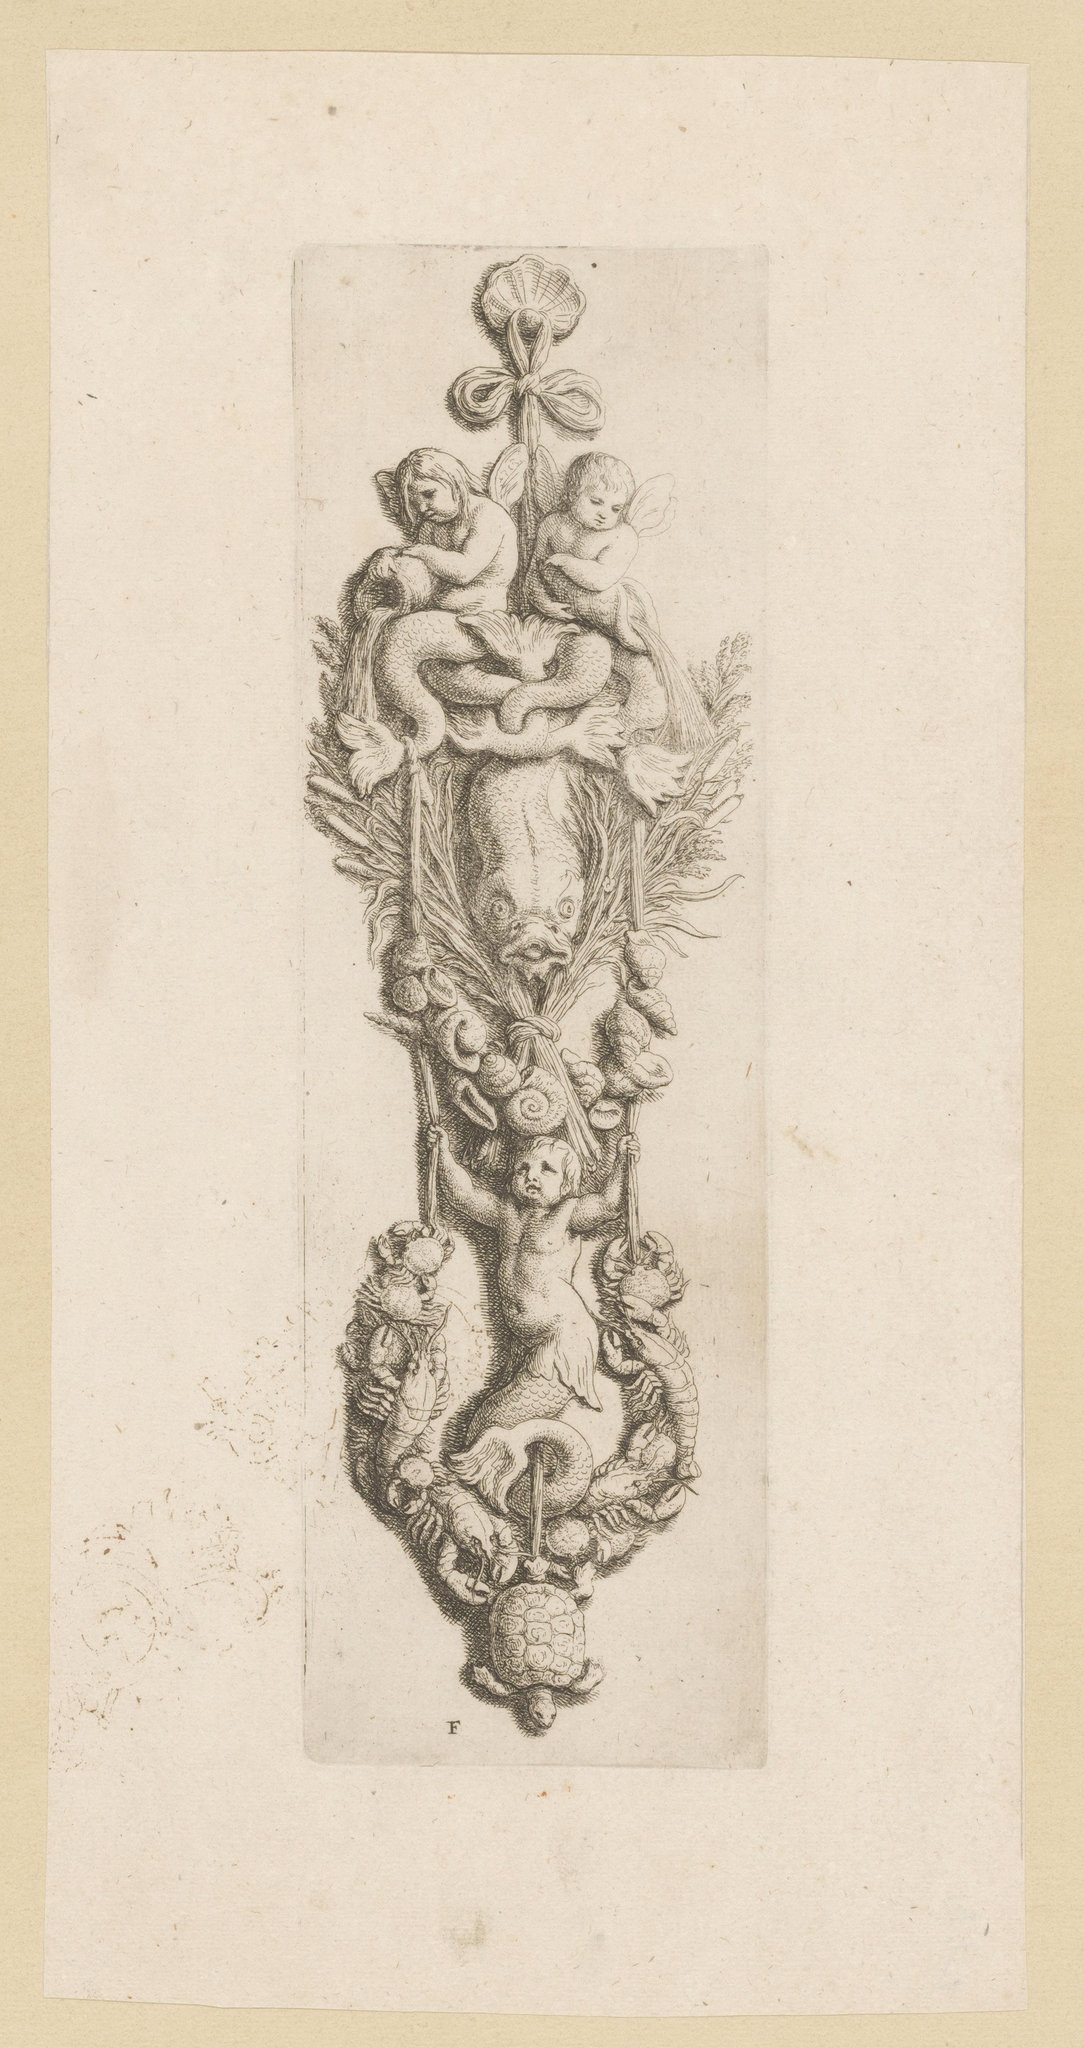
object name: print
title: Festoen met attributen van de personificatie van het element Water aan westzijde van de Burgerzaal in het Stadhuis op de Dam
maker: hubert quellinus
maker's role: print maker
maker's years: 1619-1687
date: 1663-1668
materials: paper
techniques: engraving, etching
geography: amsterdam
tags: water (one of the four elements), townhall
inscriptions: collector's mark: ‘16,75’ Lugt 1641b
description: Huidige staat van prent ook gebruikt in: Secunca pars Praecipuarum effigierum ac ornamentorum amplissime Curiae Amstelrodamensis maiori ex parte in cadido marmore effectorum per Artum Quellinium eiusdem Civitatis Statuarium / Het tweede deel Van de voornaemste Statuen ende Cieraten van 't konst-rijcke Stadt-huys van Amstelredam 'tmeeste in Marmer gemaeckt door Artus Quellinus Beelthouwer der voorseyde Stadt. Amsterdam: Artus Quellinus (I), 1663. En in: Secunca pars Praecipuarum effigierum ac ornamentorum amplissime Curiae Amstelrodamensis maiori ex parte in cadido marmore effectorum per Artum Quellinium eiusdem Civitatis Statuarium / Het tweede deel Van de voornaemste Statuen ende Cieraten van 't konst-rijcke Stadt-huys van Amstelredam 'tmeeste in Marmer gemaeckt door Artus Quellinus Beelthouwer der voorseyde Stadt. Amsterdam: Frederik de Wit, 1668. Latere staat van prent ook gebruikt in: Architecture peinture et sculpture de la Maison de Ville d'Amsterdam, representee en CIX. figures en taille-douce (…). Amsterdam: David Mortier, 1719. En in: Architecture peinture et sculpture de la Maison de Ville d'Amsterdam, representee en CIX. figures en taille-douce (…). Amsterdam: Gerard Valck, 1719. En in: Bouw schilder en beeldhouwkonst, van het Stadhuis te Amsteldam, vertoont in CIX figuuren (…). Amsterdam: Covens & Mortier & Covens Jr., s.a. (1774-1783).